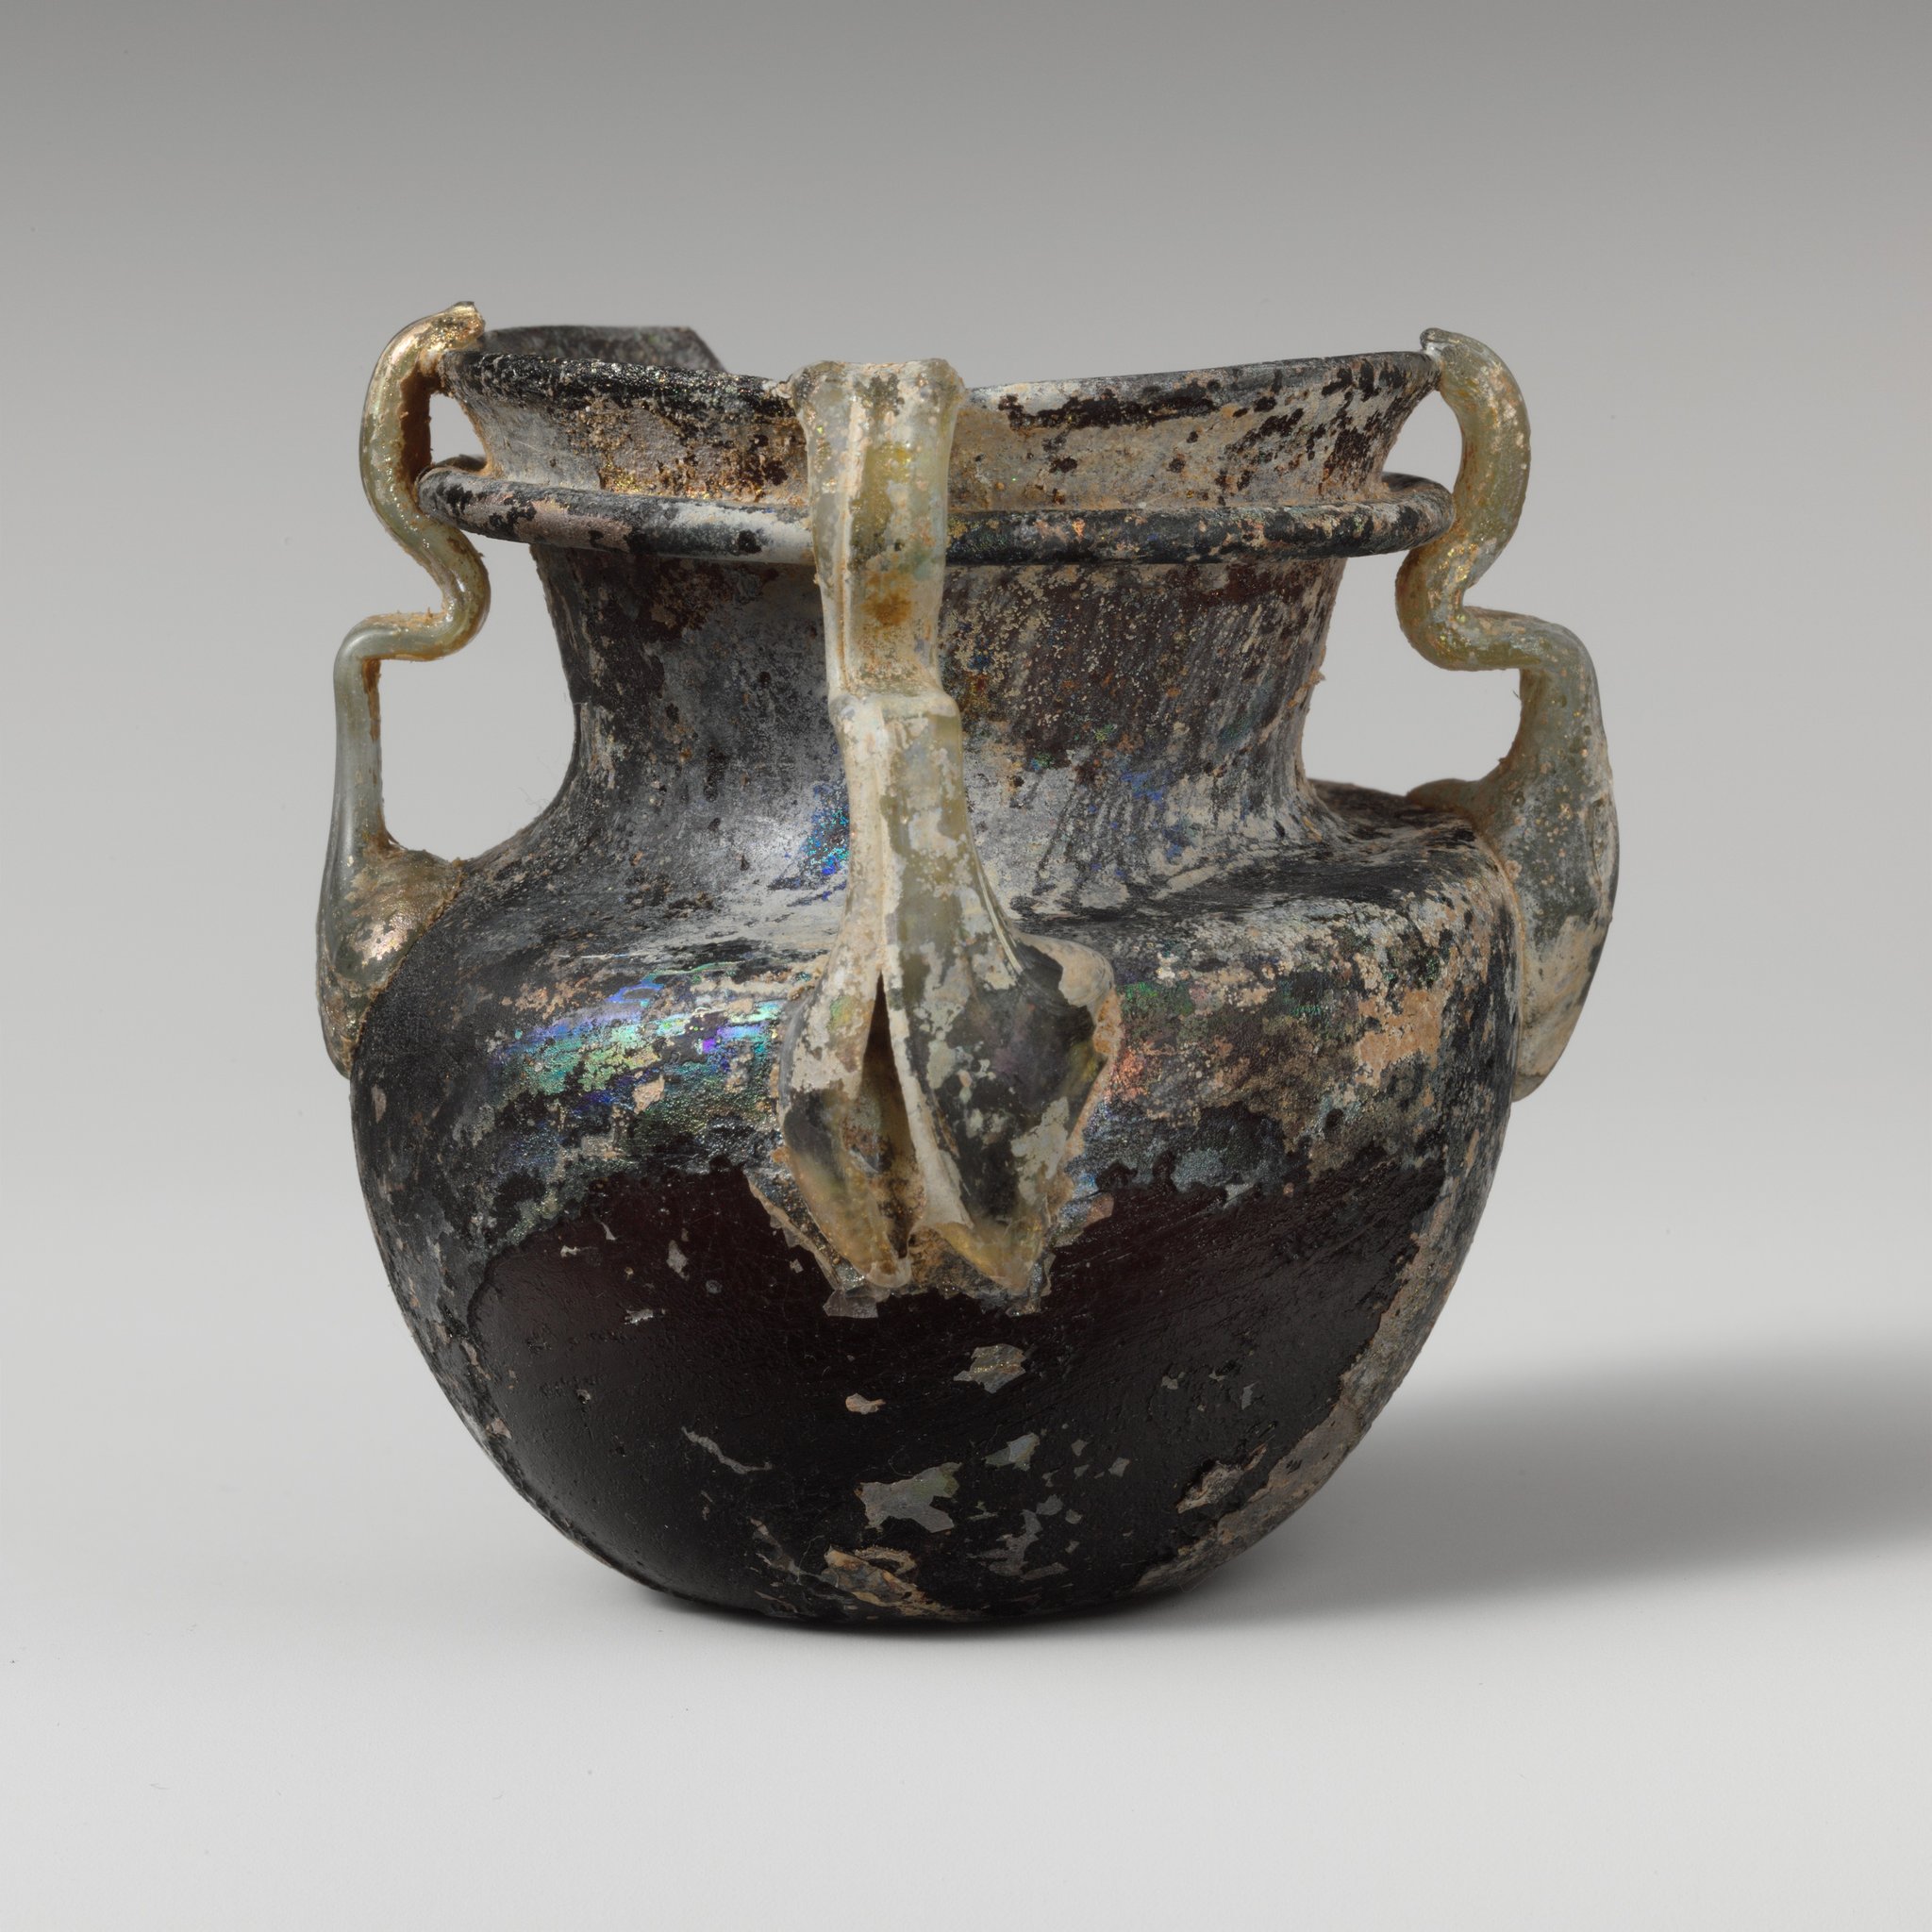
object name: jar, handled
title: Glass jar with four handles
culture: roman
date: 301-500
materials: glass